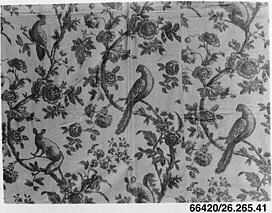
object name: floral print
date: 1800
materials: linen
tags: animals,birds,flowers,leaves